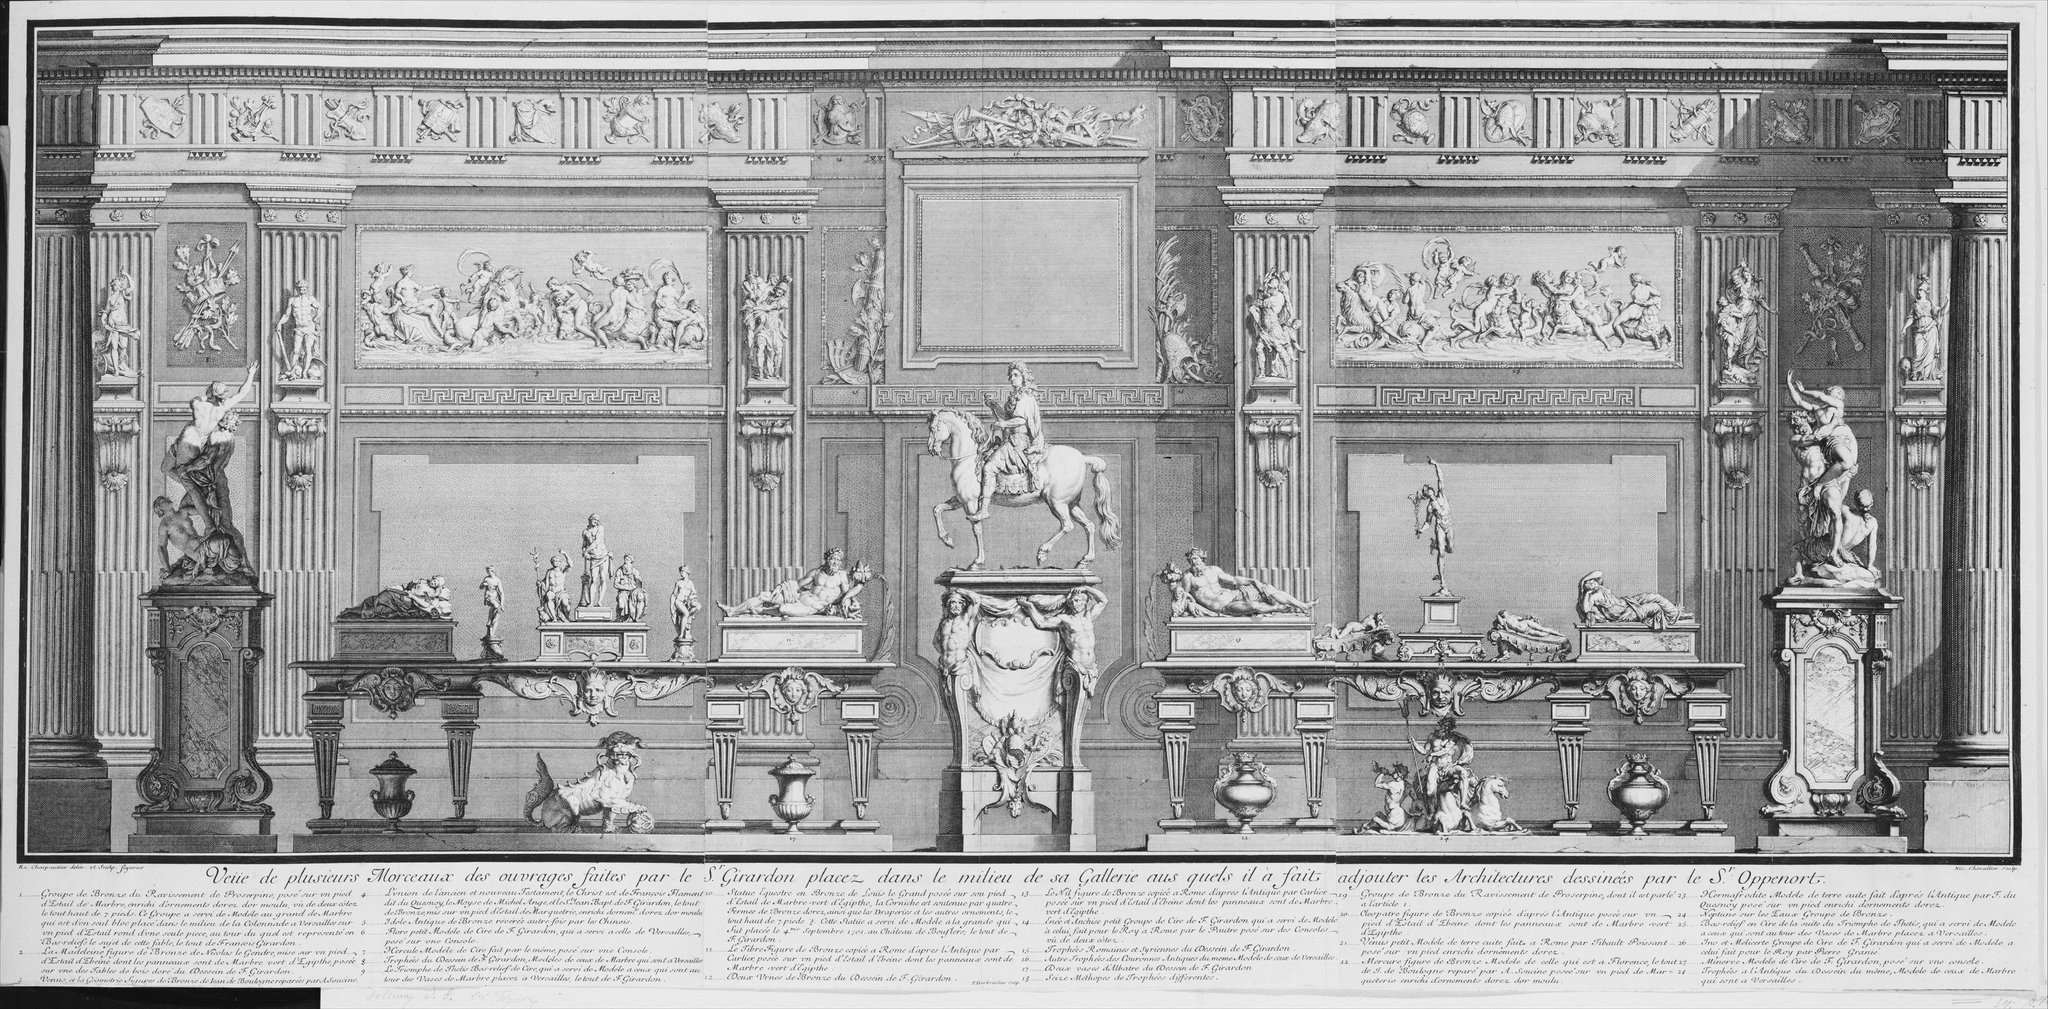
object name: print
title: La Galerie de Girardon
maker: nicolas chevalier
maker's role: artist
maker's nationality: french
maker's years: 1700-1800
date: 1701-1800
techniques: engraving, etching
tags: sculpture,horses